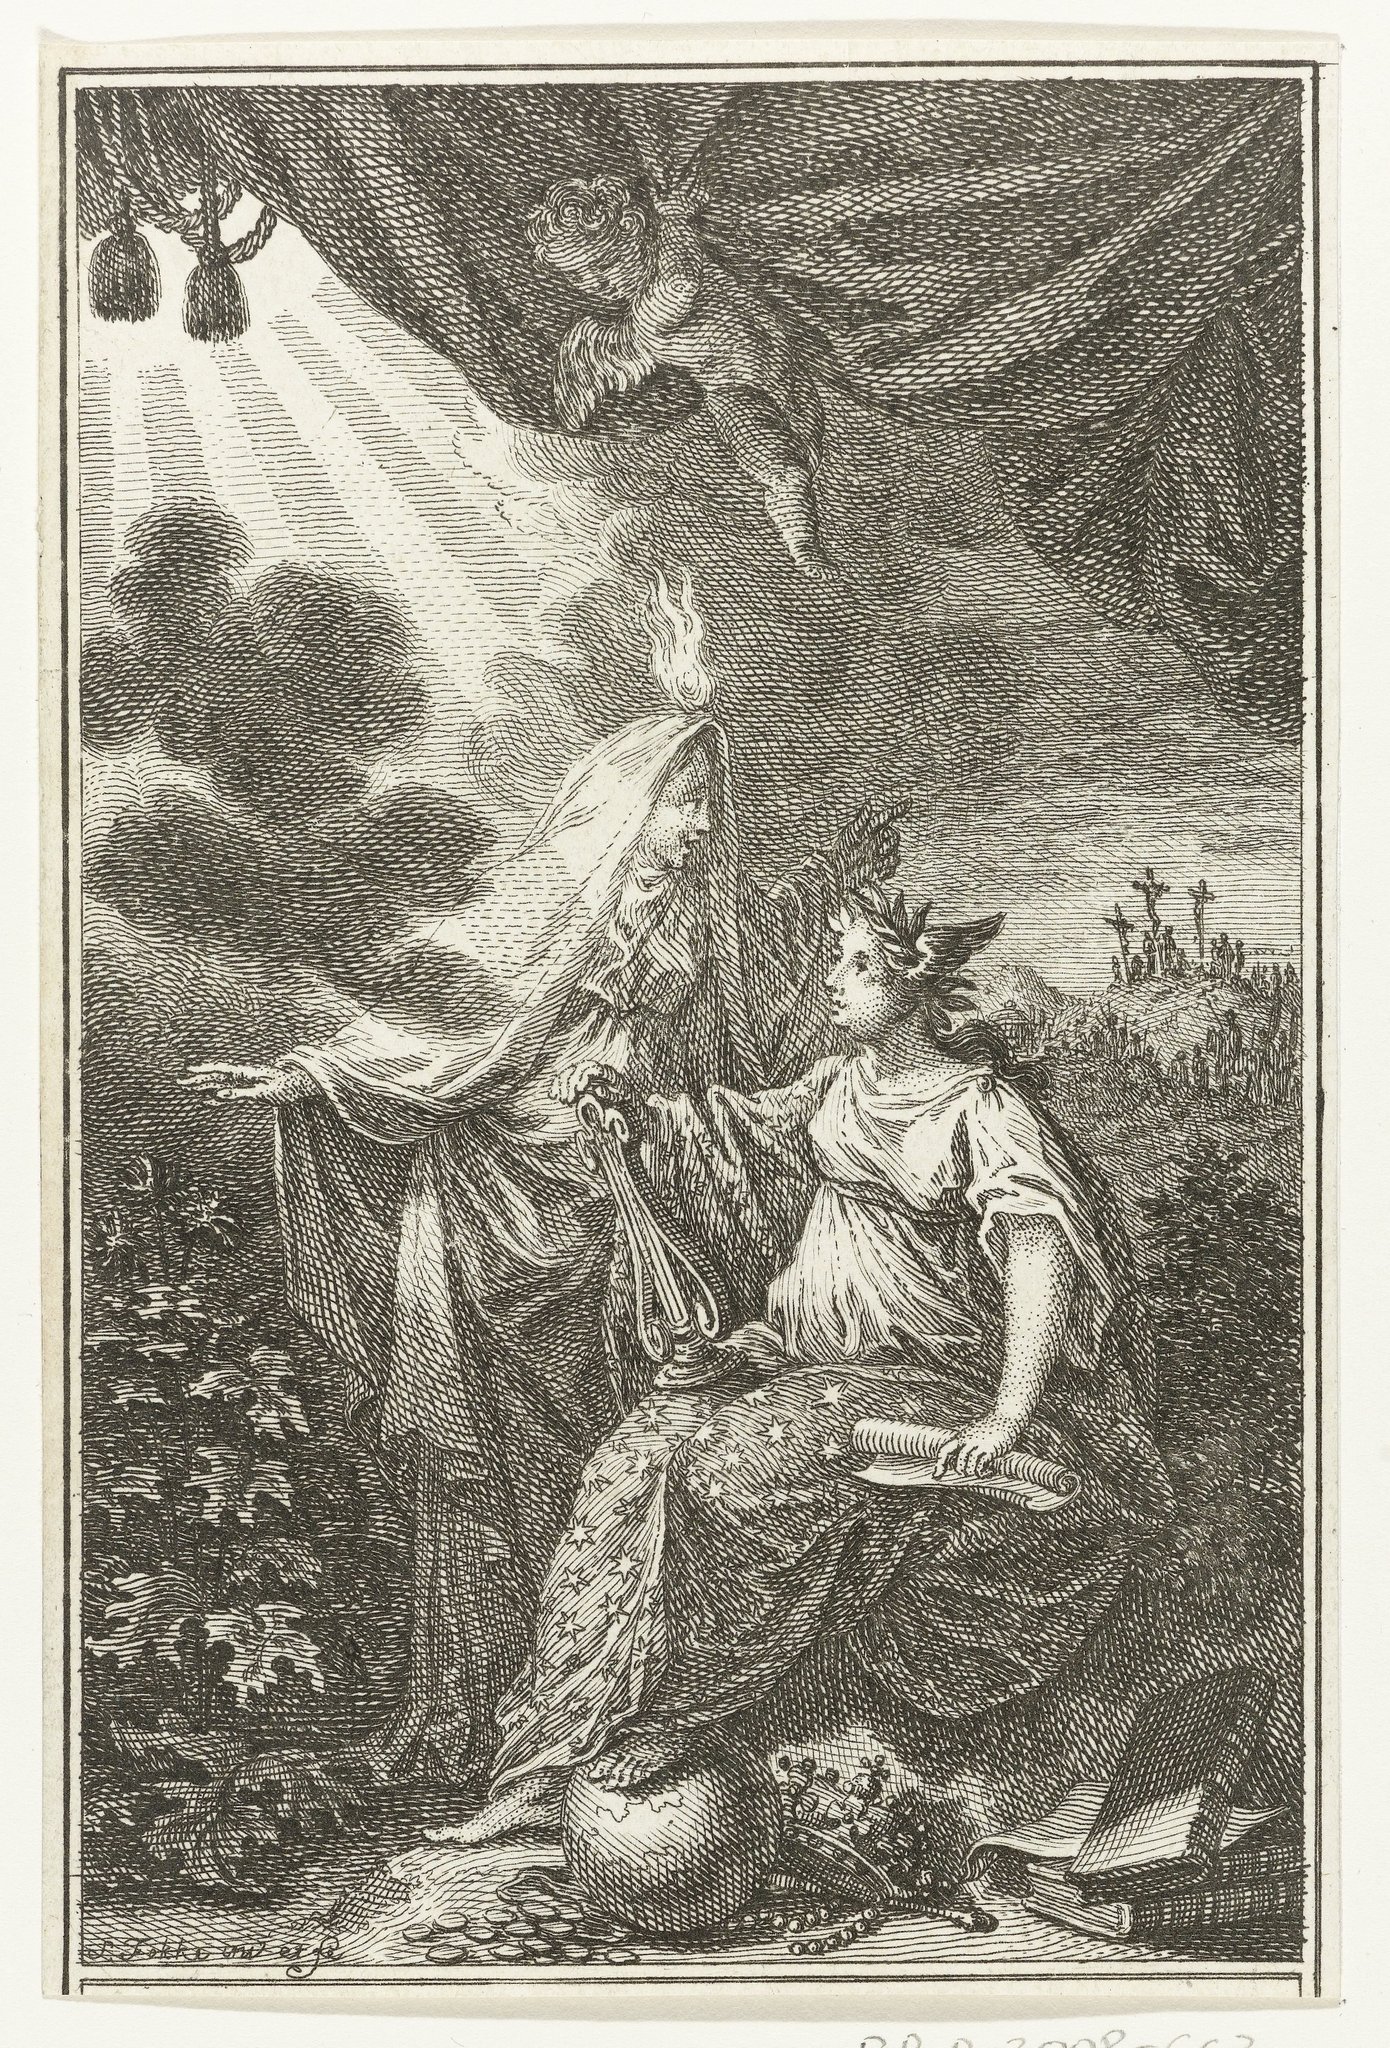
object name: print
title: Allegorische figuren nabij de heuvel Golgota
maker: simon fokke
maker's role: draughtsman, print maker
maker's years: 1712-1784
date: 1722-1784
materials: paper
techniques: engraving, etching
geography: amsterdam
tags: lyre, cithara, psaltery, the cross(es) in the background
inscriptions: collector's mark: Lugt 2760, collector's mark: Lugt 2228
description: Een gelauwerde vrouw is gehuld in een sterrenkleed en houdt zittend een rol papier en een lier in haar handen. Haar voet steunt op een wereldbol terwijl ze een gesprek voert met de gesluierde vrouw die naast haar staat. Boven het hoofd van de gesluierde vrouw brandt een vlammetje, een symbool van geloofsijver. Ze wijst op de heuvel Golgota in de verte, waar Christus aan het kruis hangt. Op de voorgrond liggen naast de wereldbol boeken, een kroon en geld.